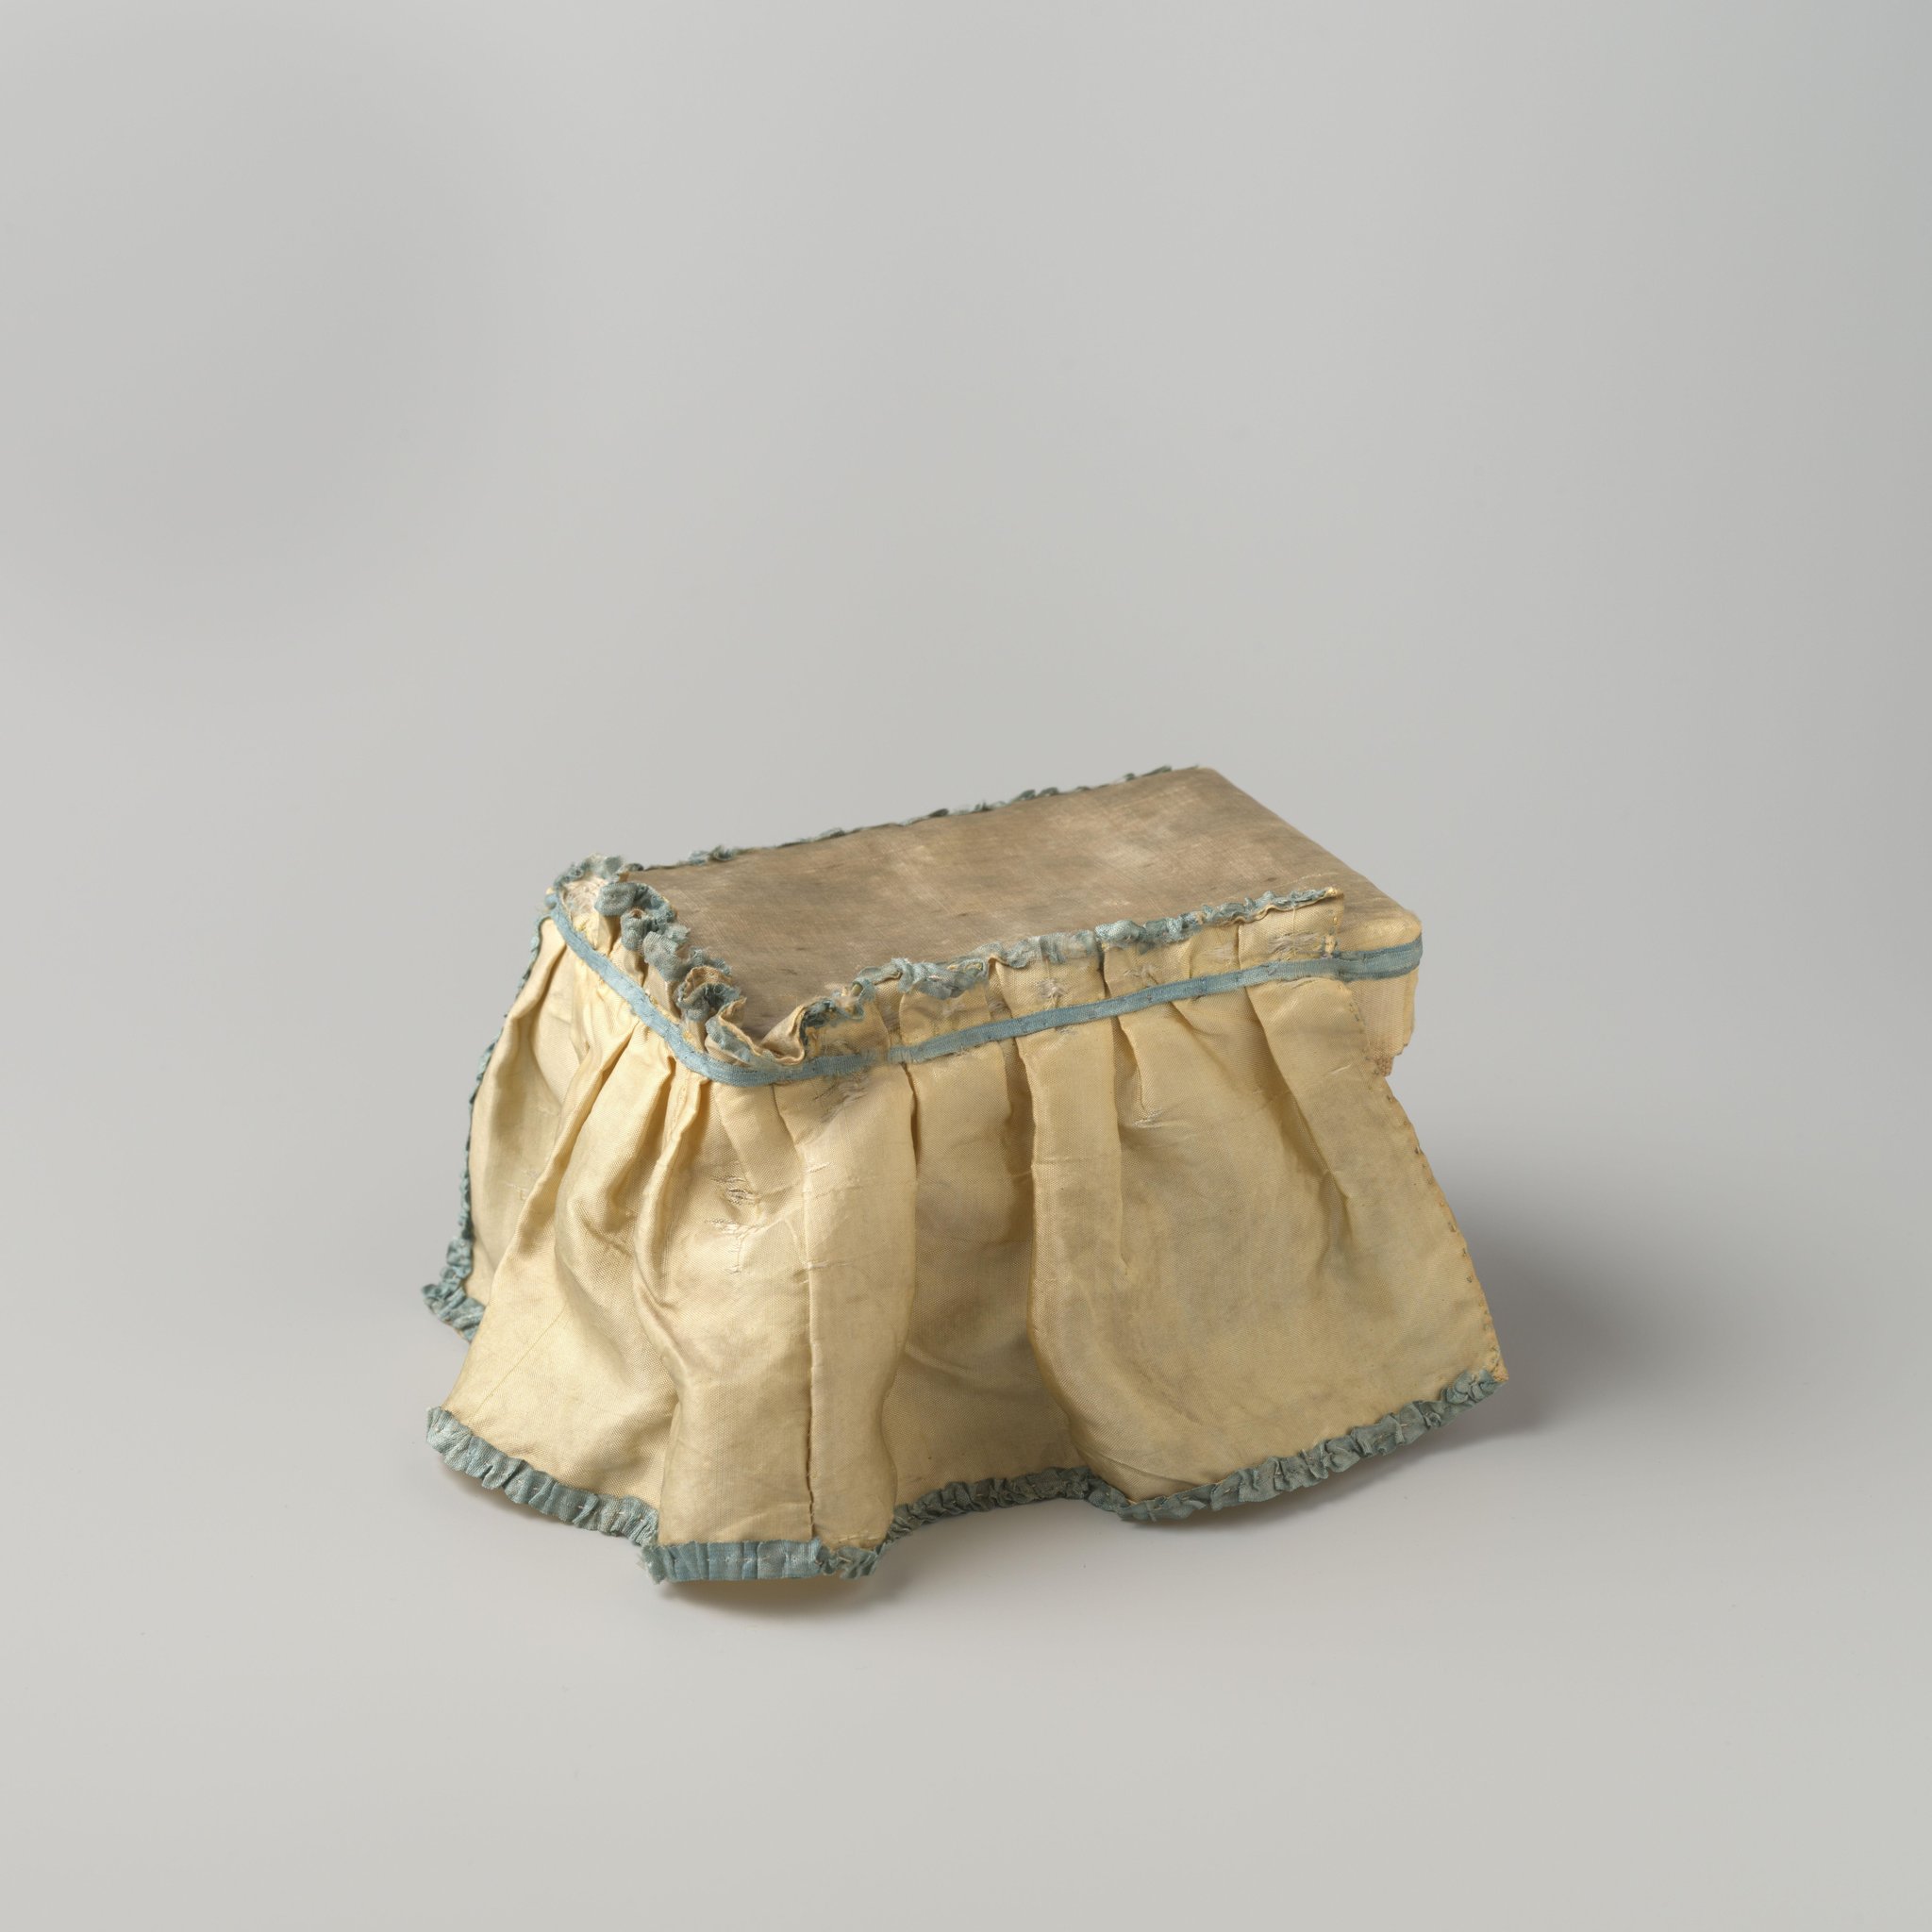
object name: tafelkleed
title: Tafelkleed vervaardigd van licht gele zijde.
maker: Anonymous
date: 1690-1710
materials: linen, silk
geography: amsterdam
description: Tafelkleed, vervaardigd van licht gele zijde, afgezet met een ingerimpeld licht blauw zijden lintje; de constructie bestaat uit een rechthoekig bovenblad, waaraan een ( nu nog slechts over twee zijden) doorlopende streek geplooid is aangezet. De strook steekt boven het blad.